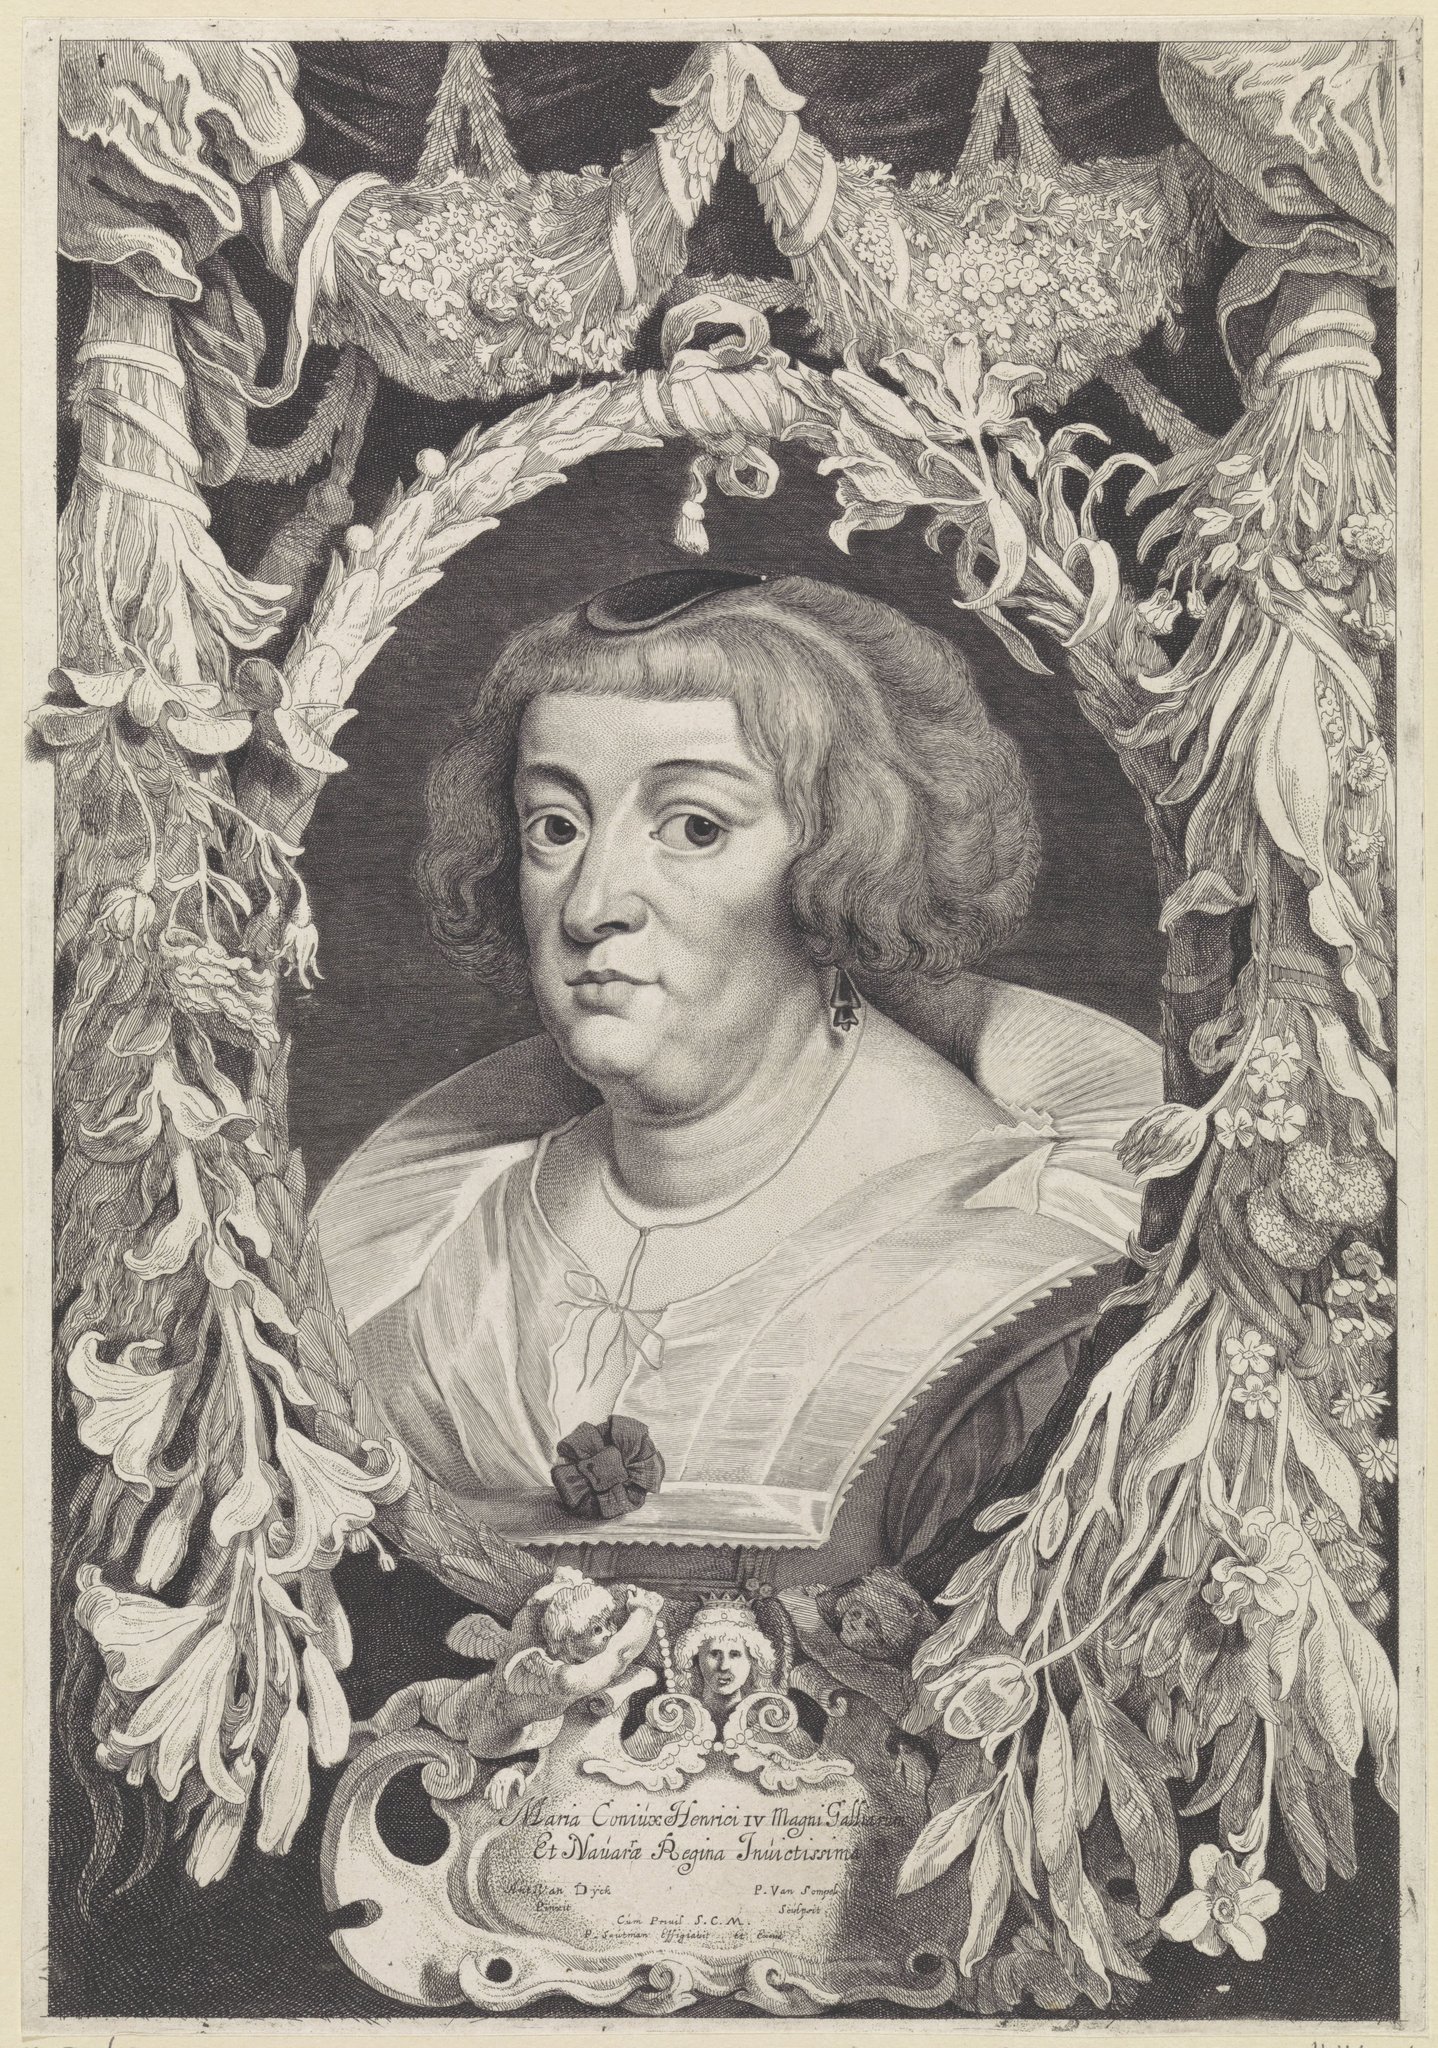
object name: print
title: Ferdinandus II[us] et III[us] Imperatorum Domus Austriacae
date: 1644-1650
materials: paper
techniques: engraving, etching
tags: cologne, print maker, maria de' medici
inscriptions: collector's mark: Lugt 240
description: Portret van Maria de' Medici. Het portret wordt omlijst door een lauwerkrans en guirlandes met bloemen. Onder het portret een cartouche met in het Latijn haar naam, haar titels en de naam van haar echtgenoot, de Franse koning Hendrik IV.